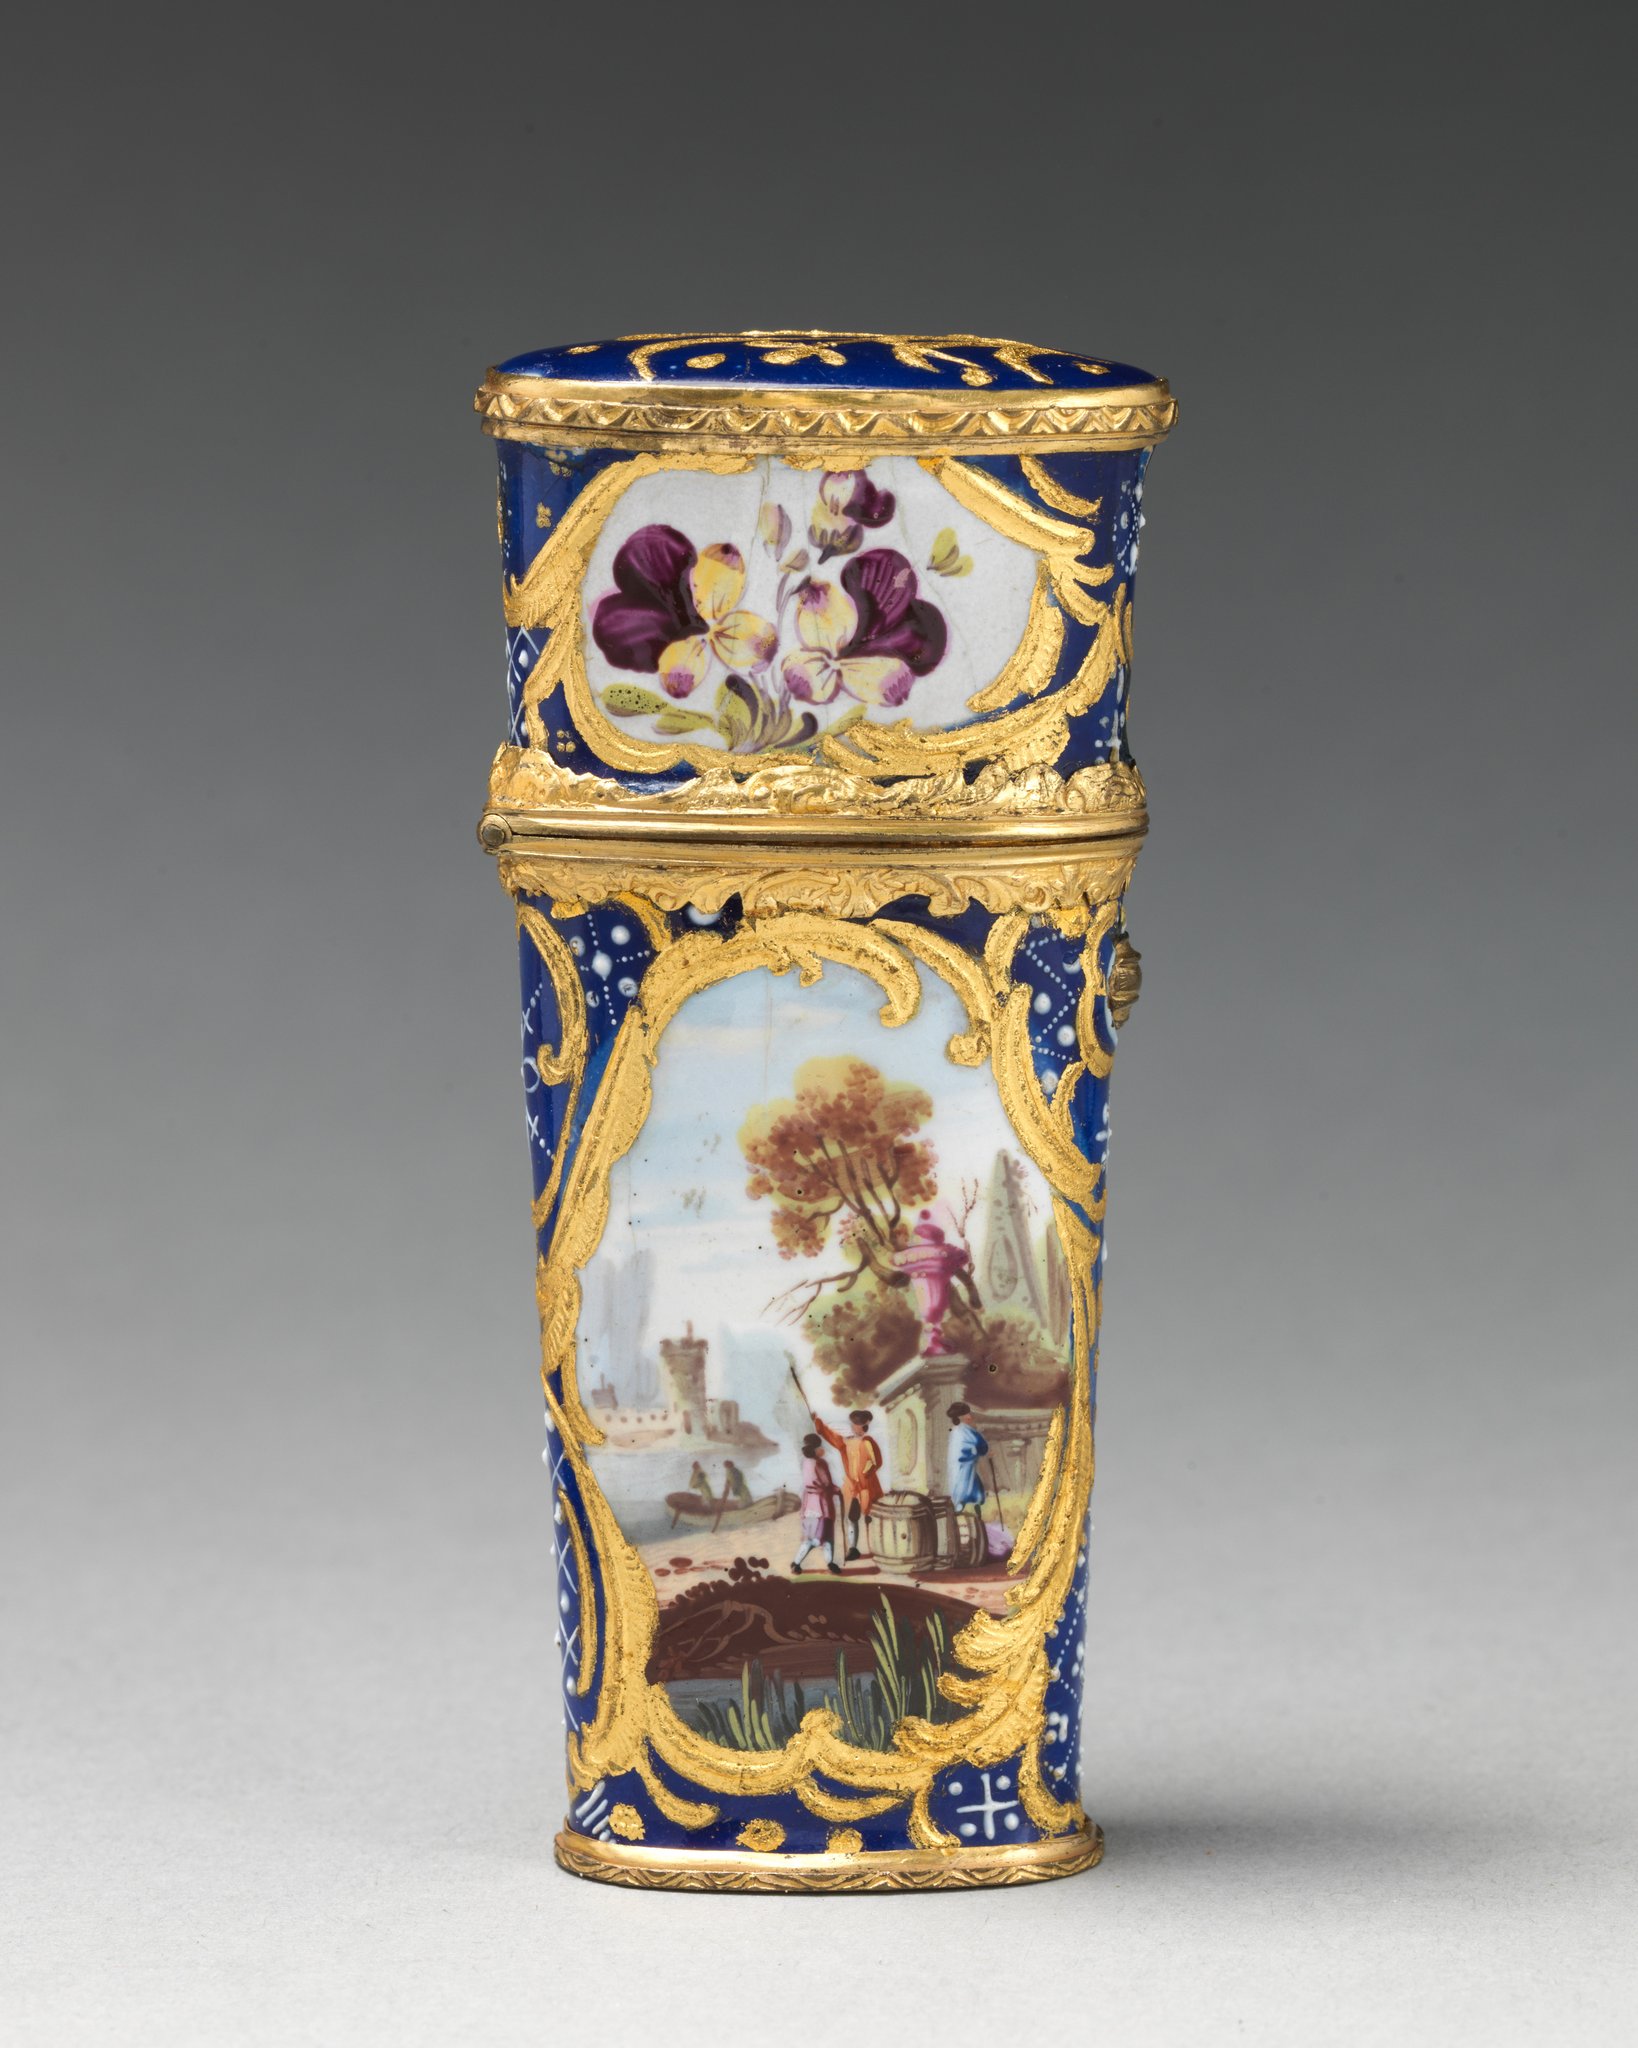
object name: étui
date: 1765-1770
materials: copper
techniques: enamel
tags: horses,flowers,trees